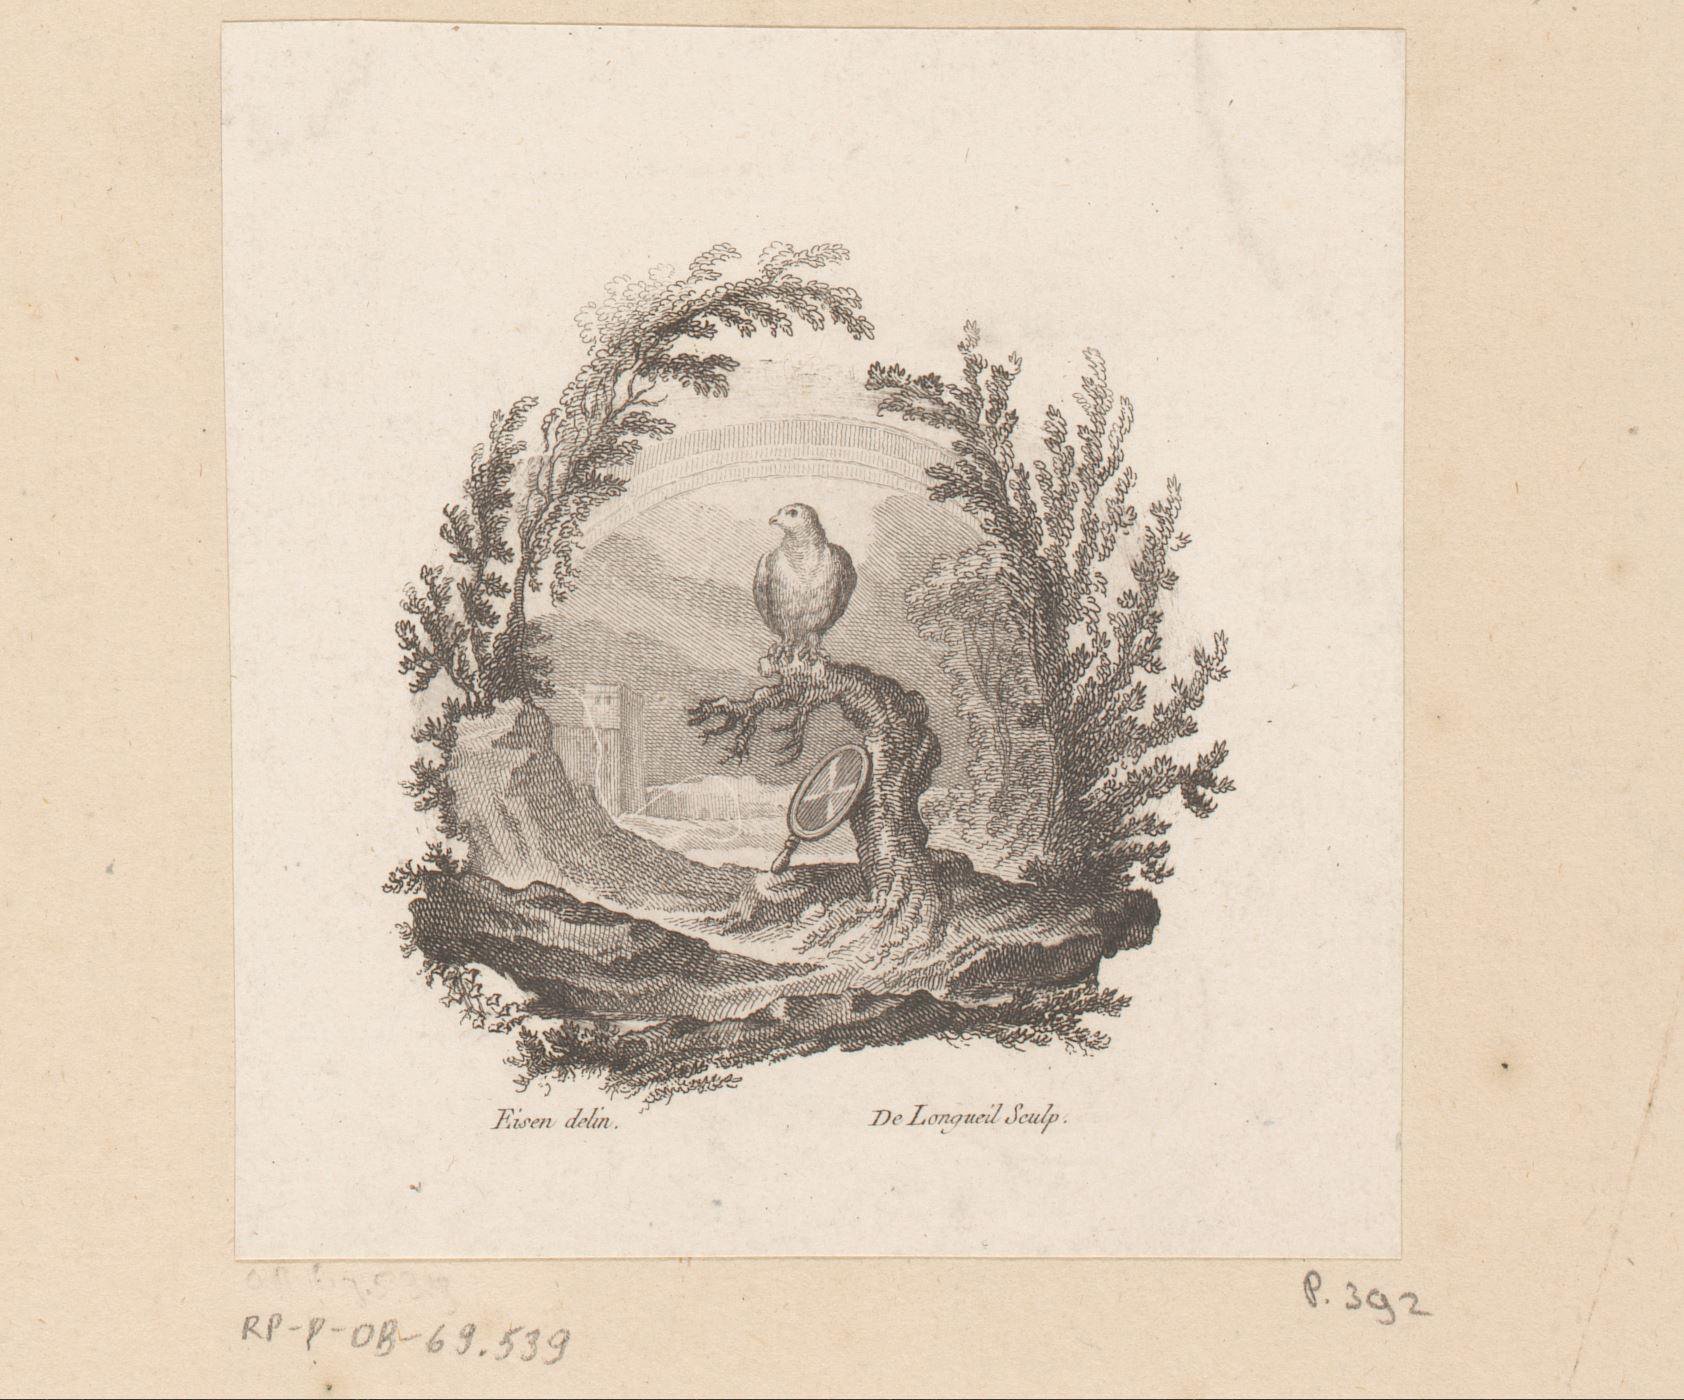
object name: print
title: Zintuigen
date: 1765-1792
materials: paper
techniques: engraving, etching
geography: france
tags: mirror, predatory birds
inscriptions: collector's mark: Lugt 240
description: Mogelijk prent uit een boek of serie: 'Les sens'.